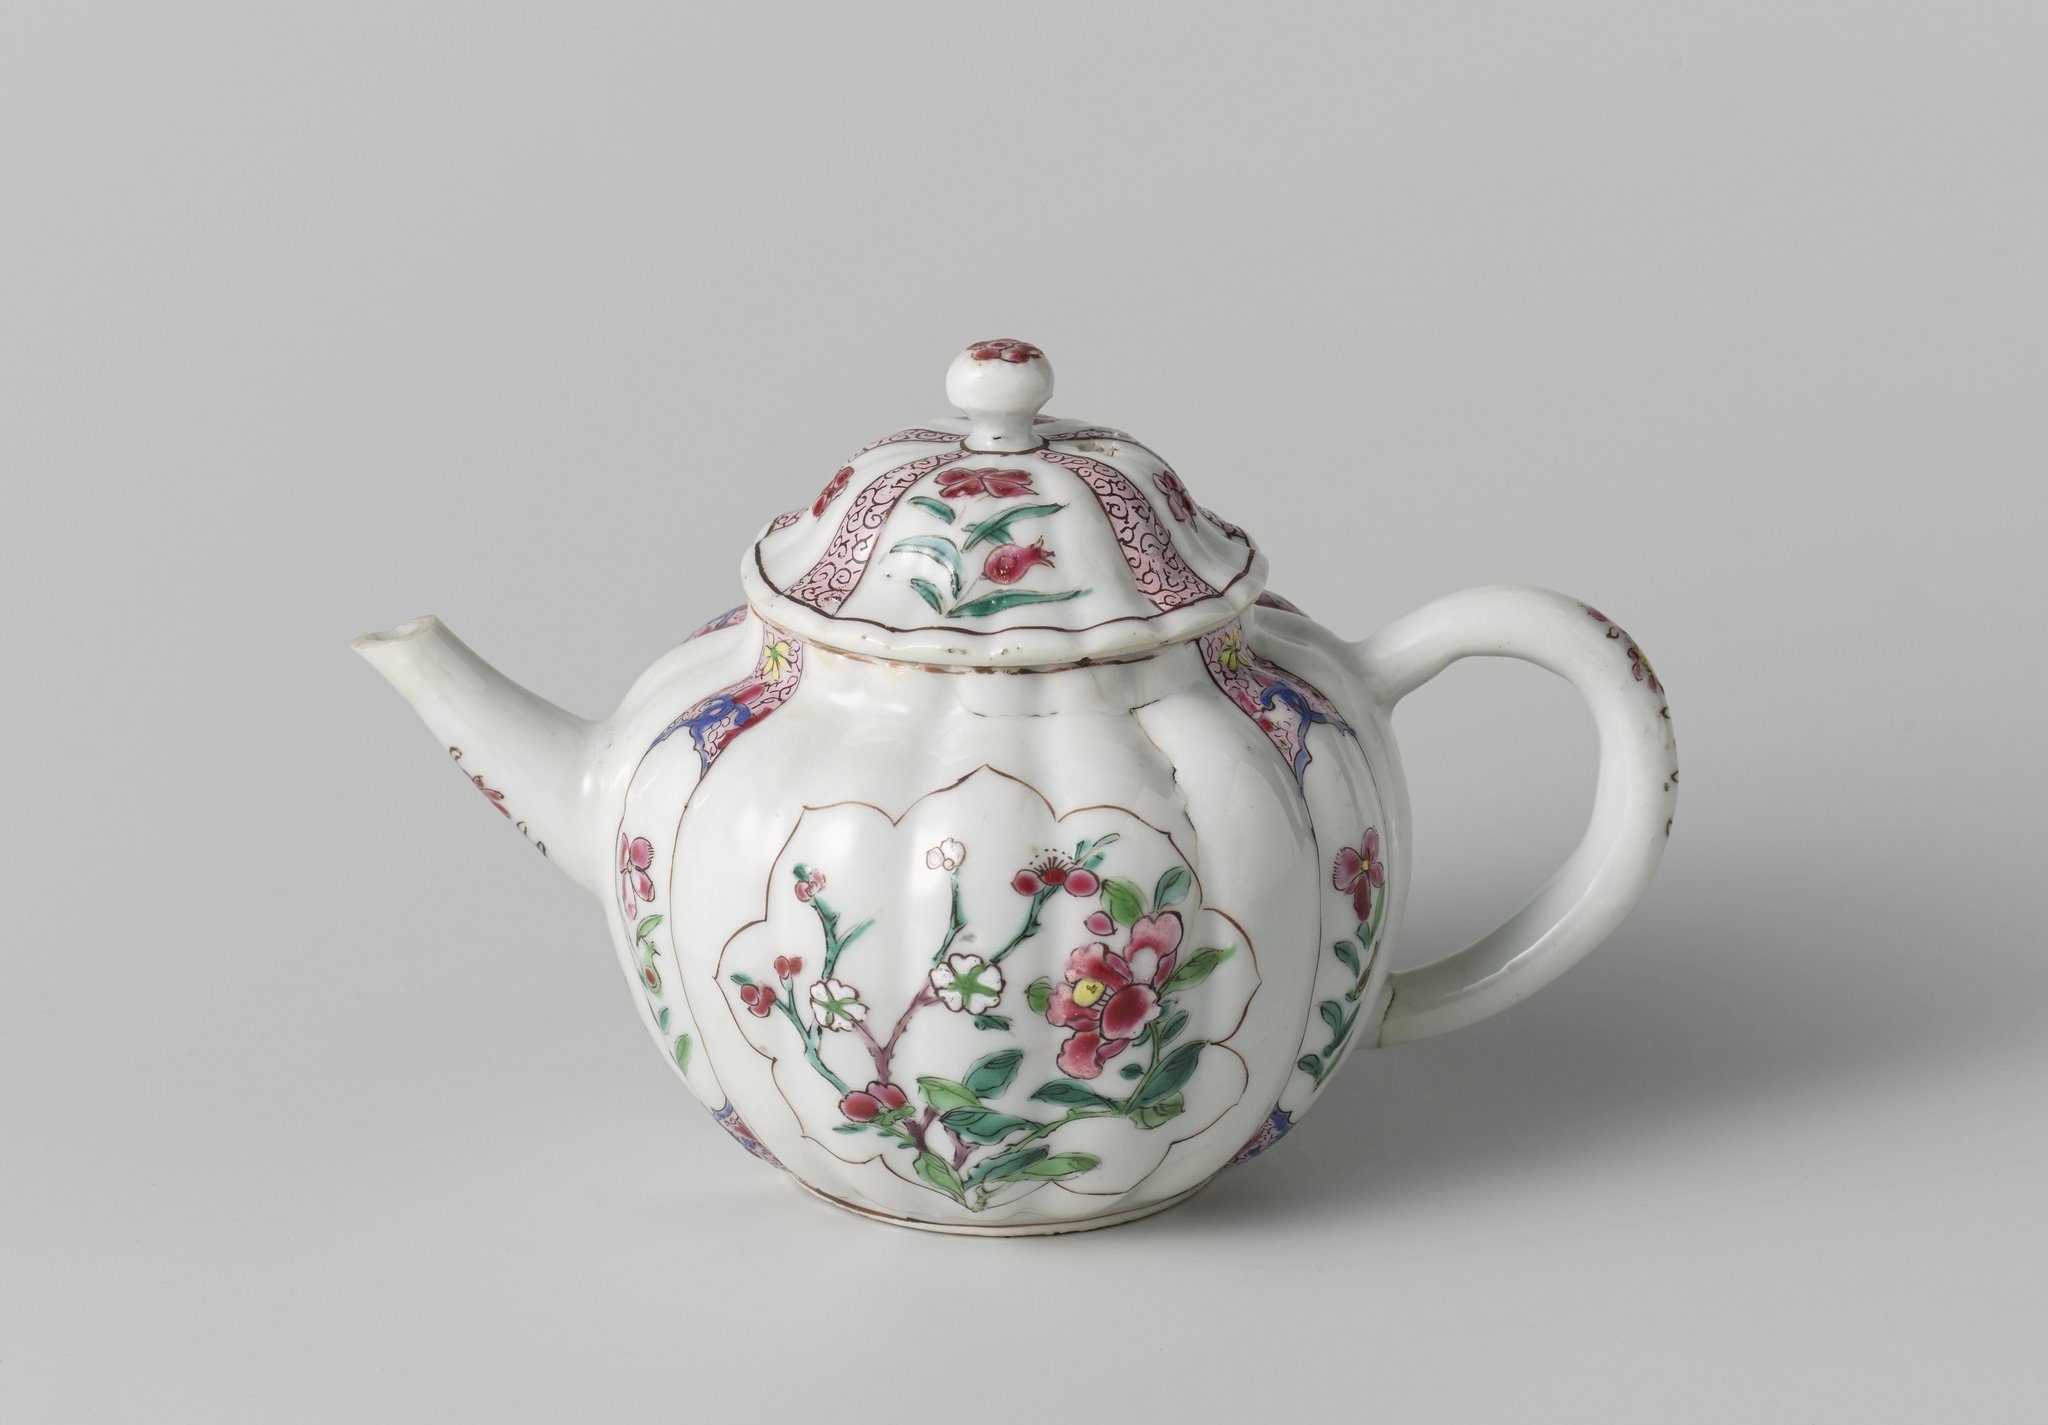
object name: teapot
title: Fluted tea pot with flower sprays in panels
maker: Anonymous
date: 1725-1749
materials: glaze, paint, porcelain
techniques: firing, forming, turning, vitrification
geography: china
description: Geribde theepot van porselein met een rechte tuit en C-vormig oor, beschilderd op het glazuur in blauw, rood, roze, groen, geel en zwart. Op de wand een bloemvormig cartouche met daarin verschillende bloemtakken. Aan weerszijden van oor en tuit een verticaal, smal vak met bloemen op servetwerk onderbroken door een cartouche met een bloemtak. De deksel is verdeeld in vier vakken met bloeiende planten, gescheiden door smalle banden met krulwerk. Het oor en de tuit met bloemranken. Famille rose.